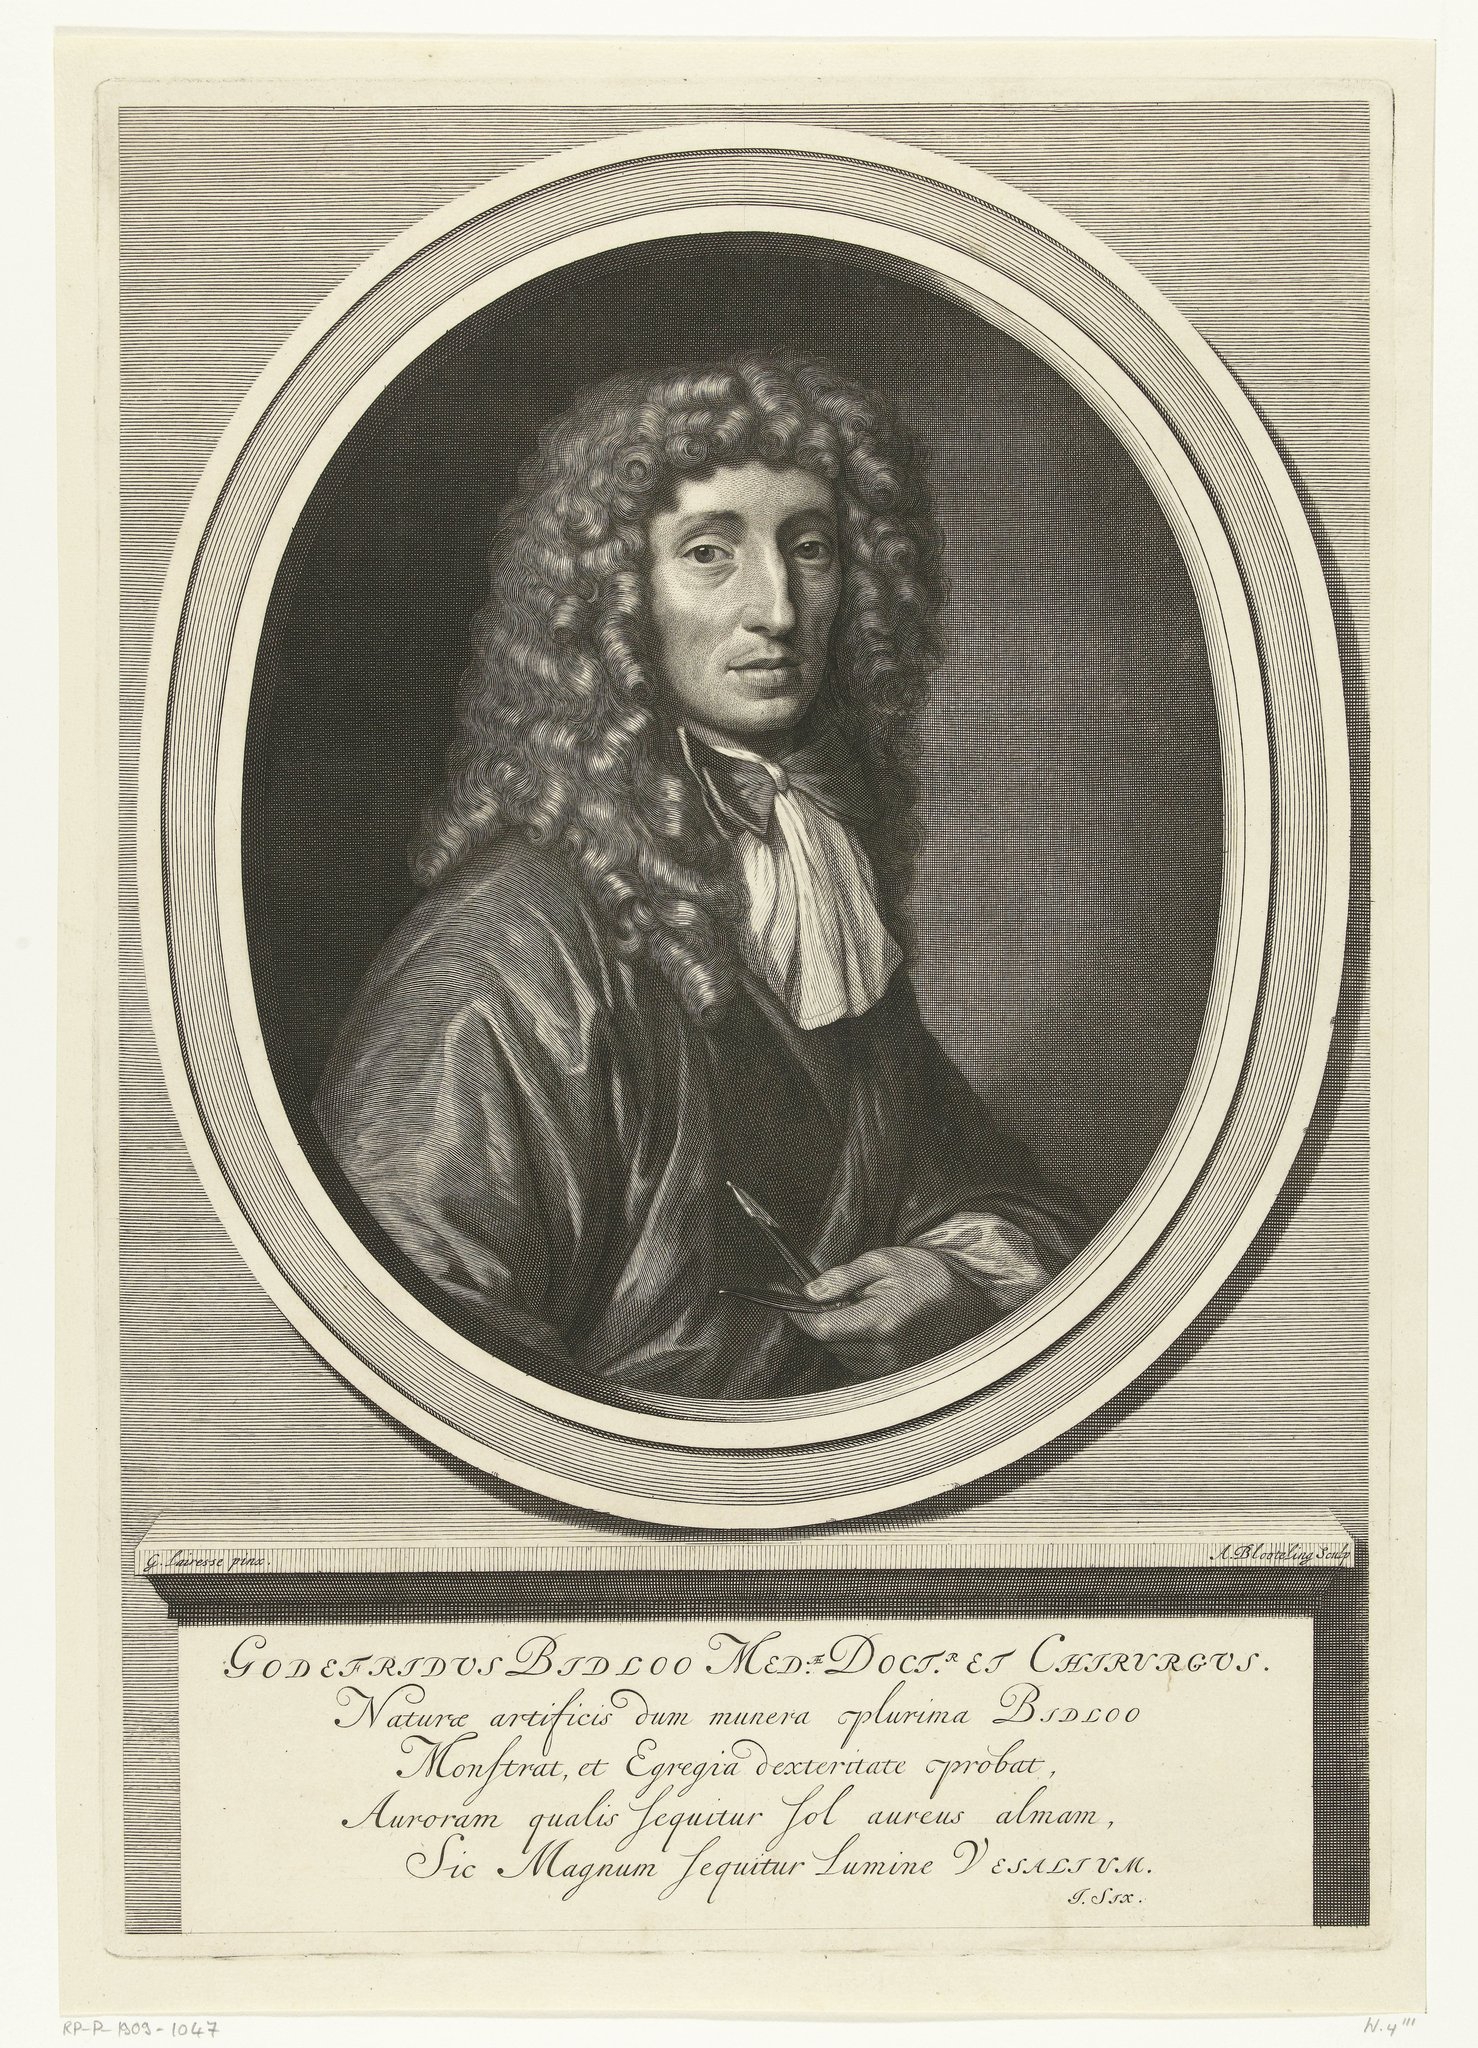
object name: print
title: Portret van Goverd Bidloo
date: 1680-1690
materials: paper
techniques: engraving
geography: amsterdam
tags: amsterdam, leiden, govard bidloo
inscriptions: collector's mark: Lugt 2228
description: Borstbeeld van de dichter en lijfarts van Willem III, Goverd Bidloo. Bidloo houdt een mes in zijn handen, als symbool voor zijn werk als chirurgijn.